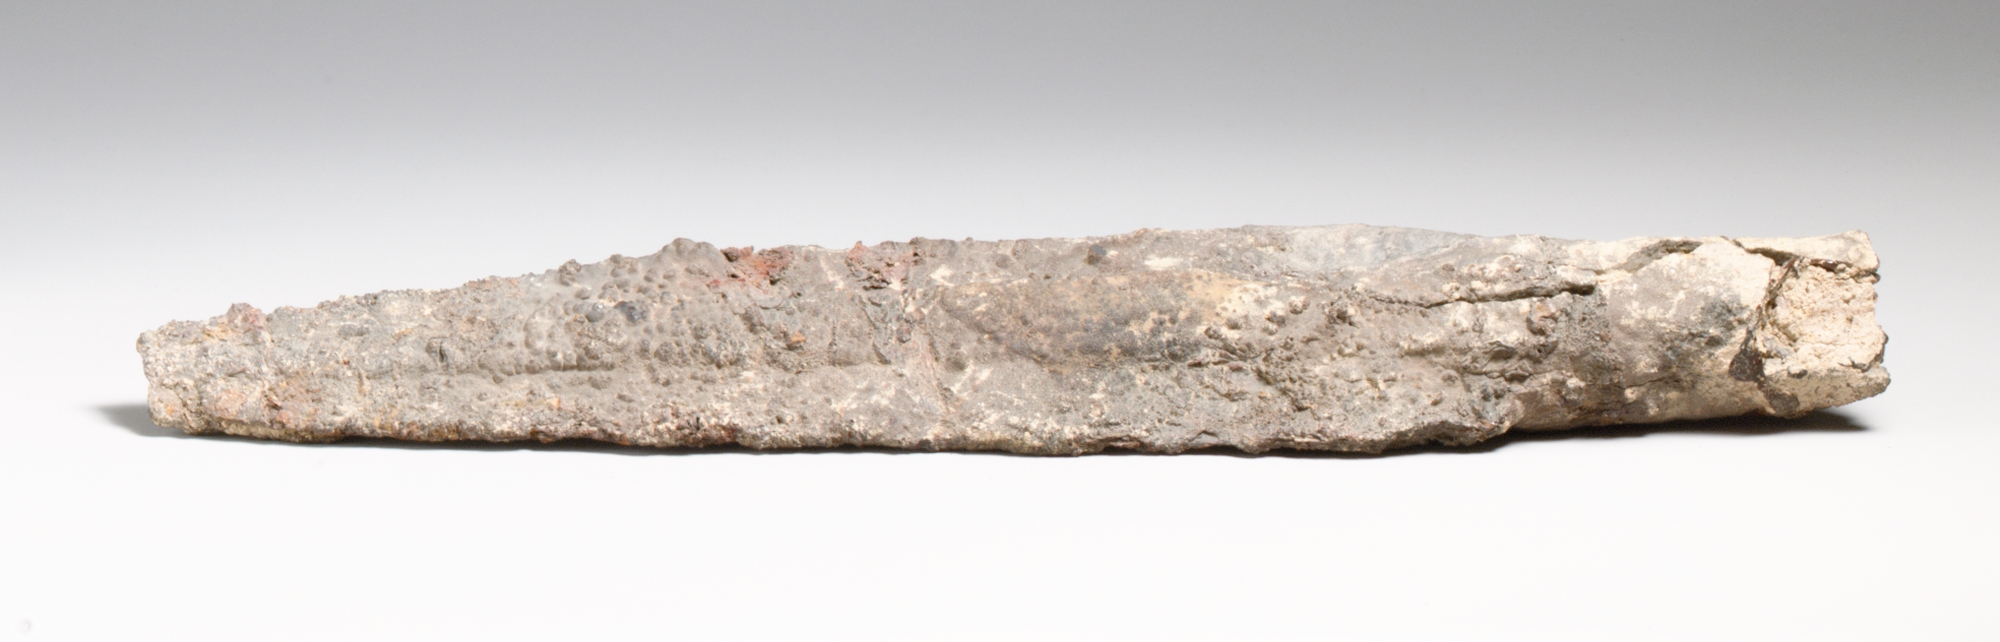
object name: spearhead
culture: cypriot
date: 1050-1000 BCE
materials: iron